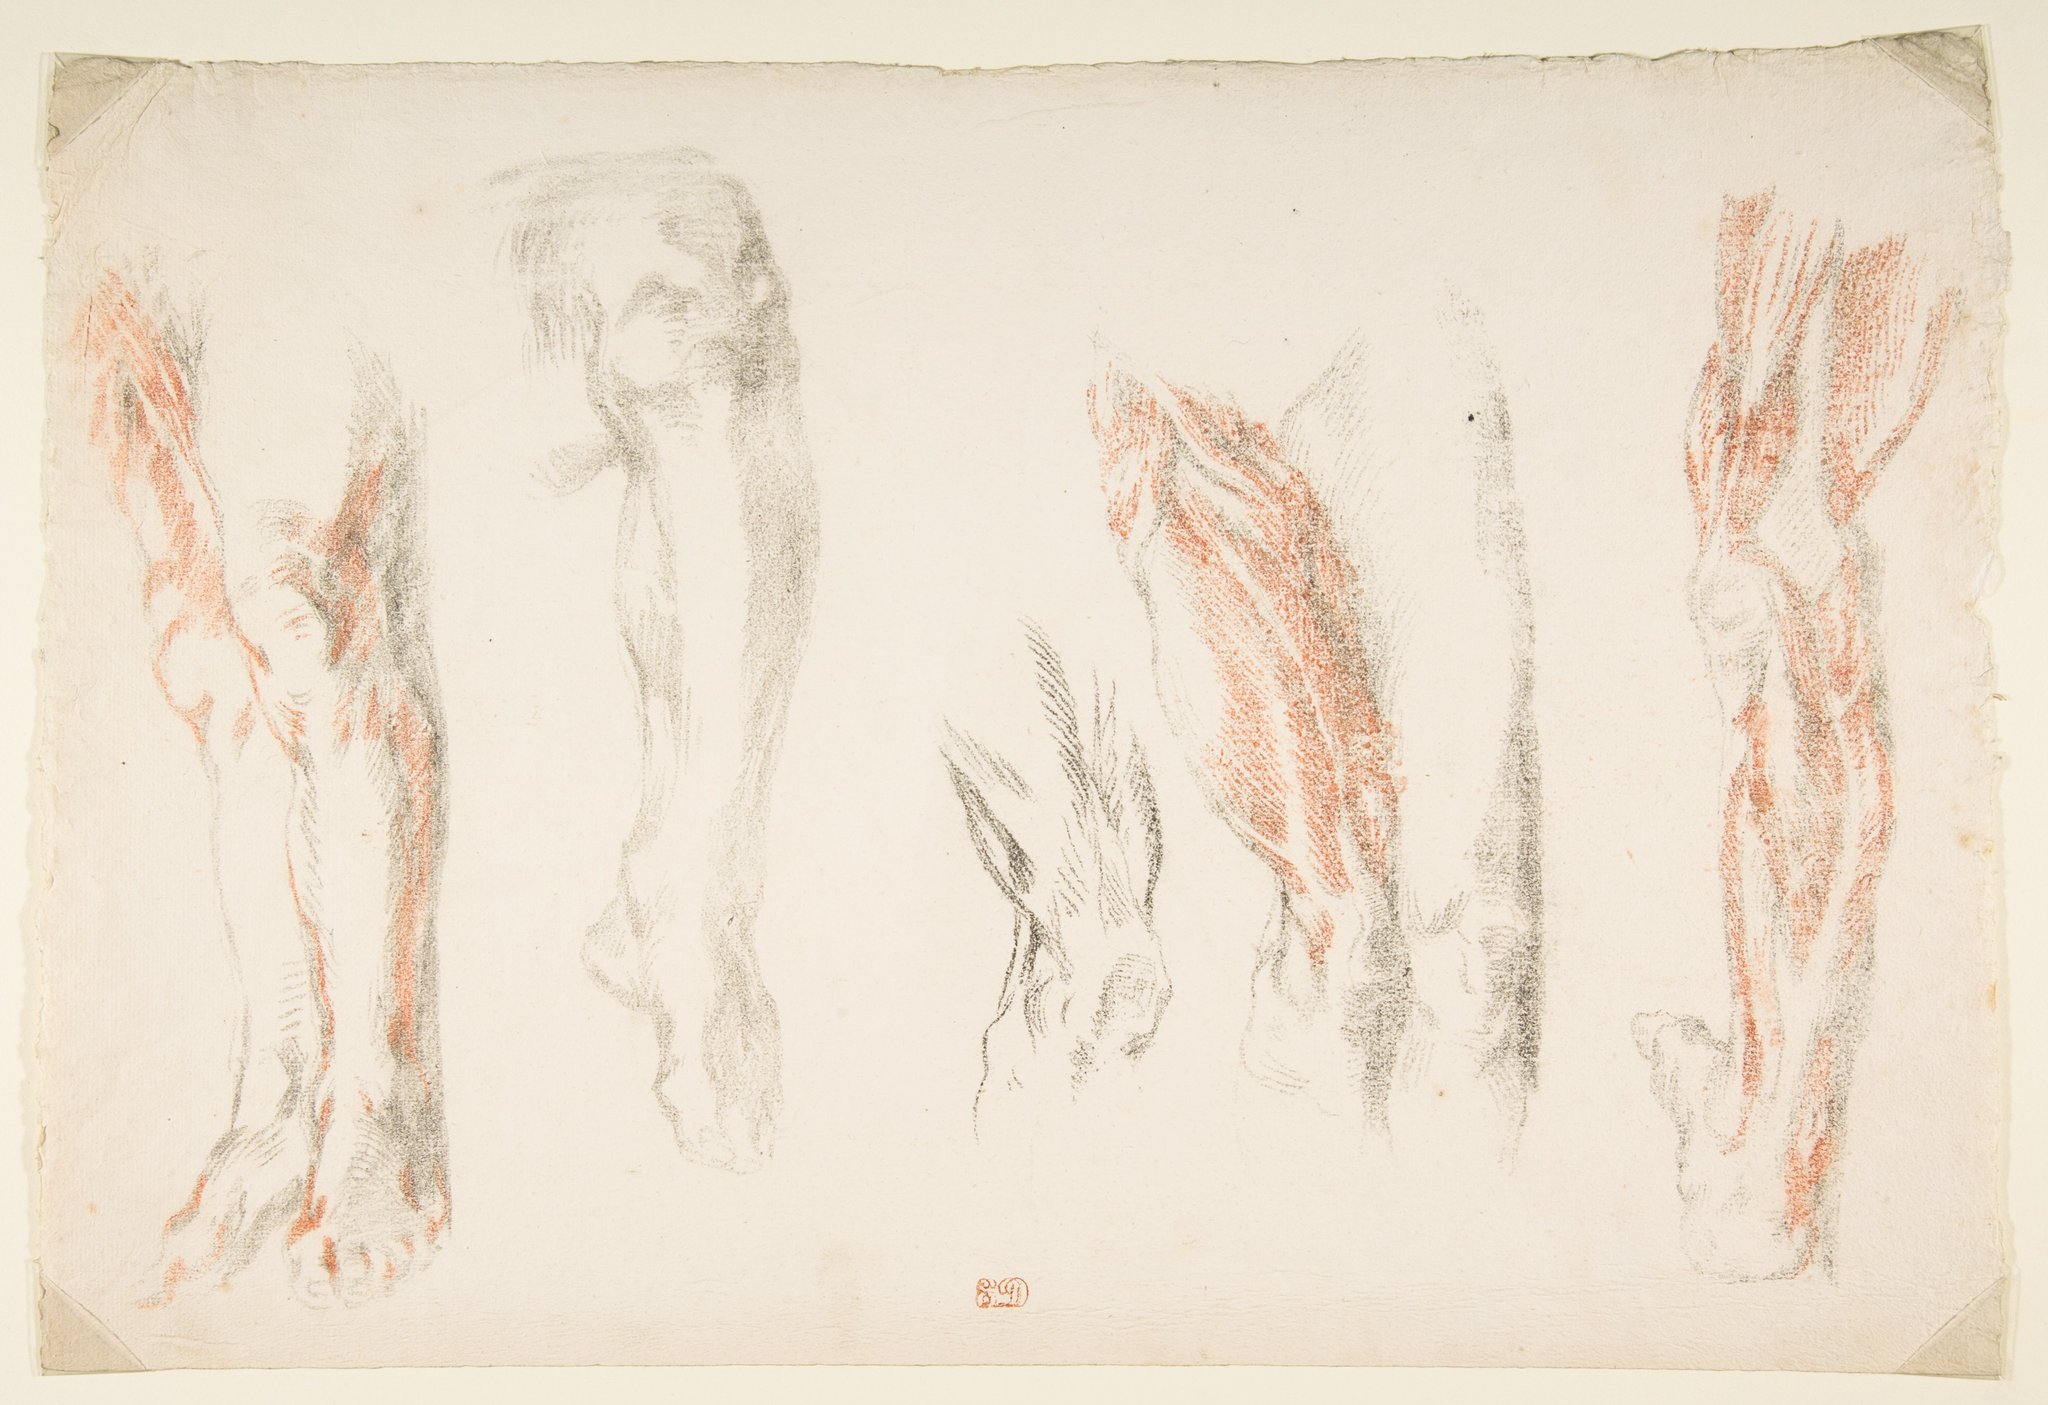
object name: drawing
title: Anatomical Studies of Legs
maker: eugène delacroix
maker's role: artist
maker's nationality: french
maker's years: 1798-1863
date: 1810-1863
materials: chalk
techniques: printmaking, drawing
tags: legs